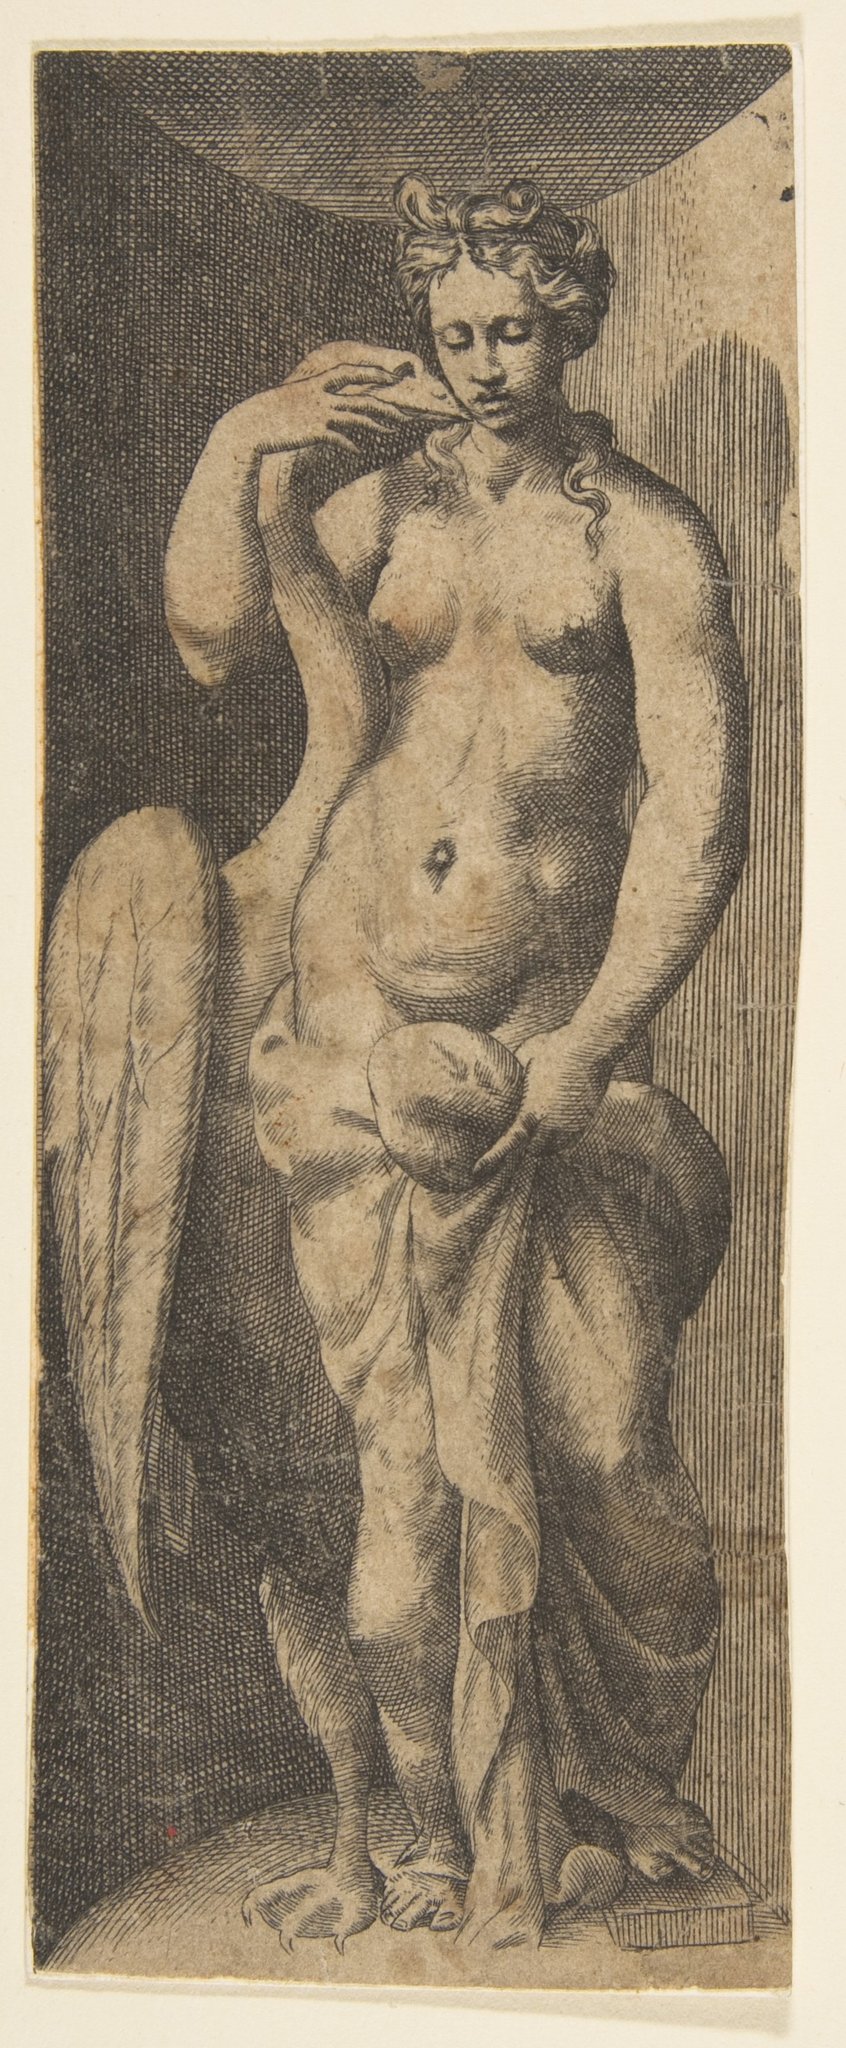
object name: print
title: Leda and the swan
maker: giulio bonasone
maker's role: artist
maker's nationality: italian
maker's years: 1510-1576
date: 1531-1576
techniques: engraving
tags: leda,swans